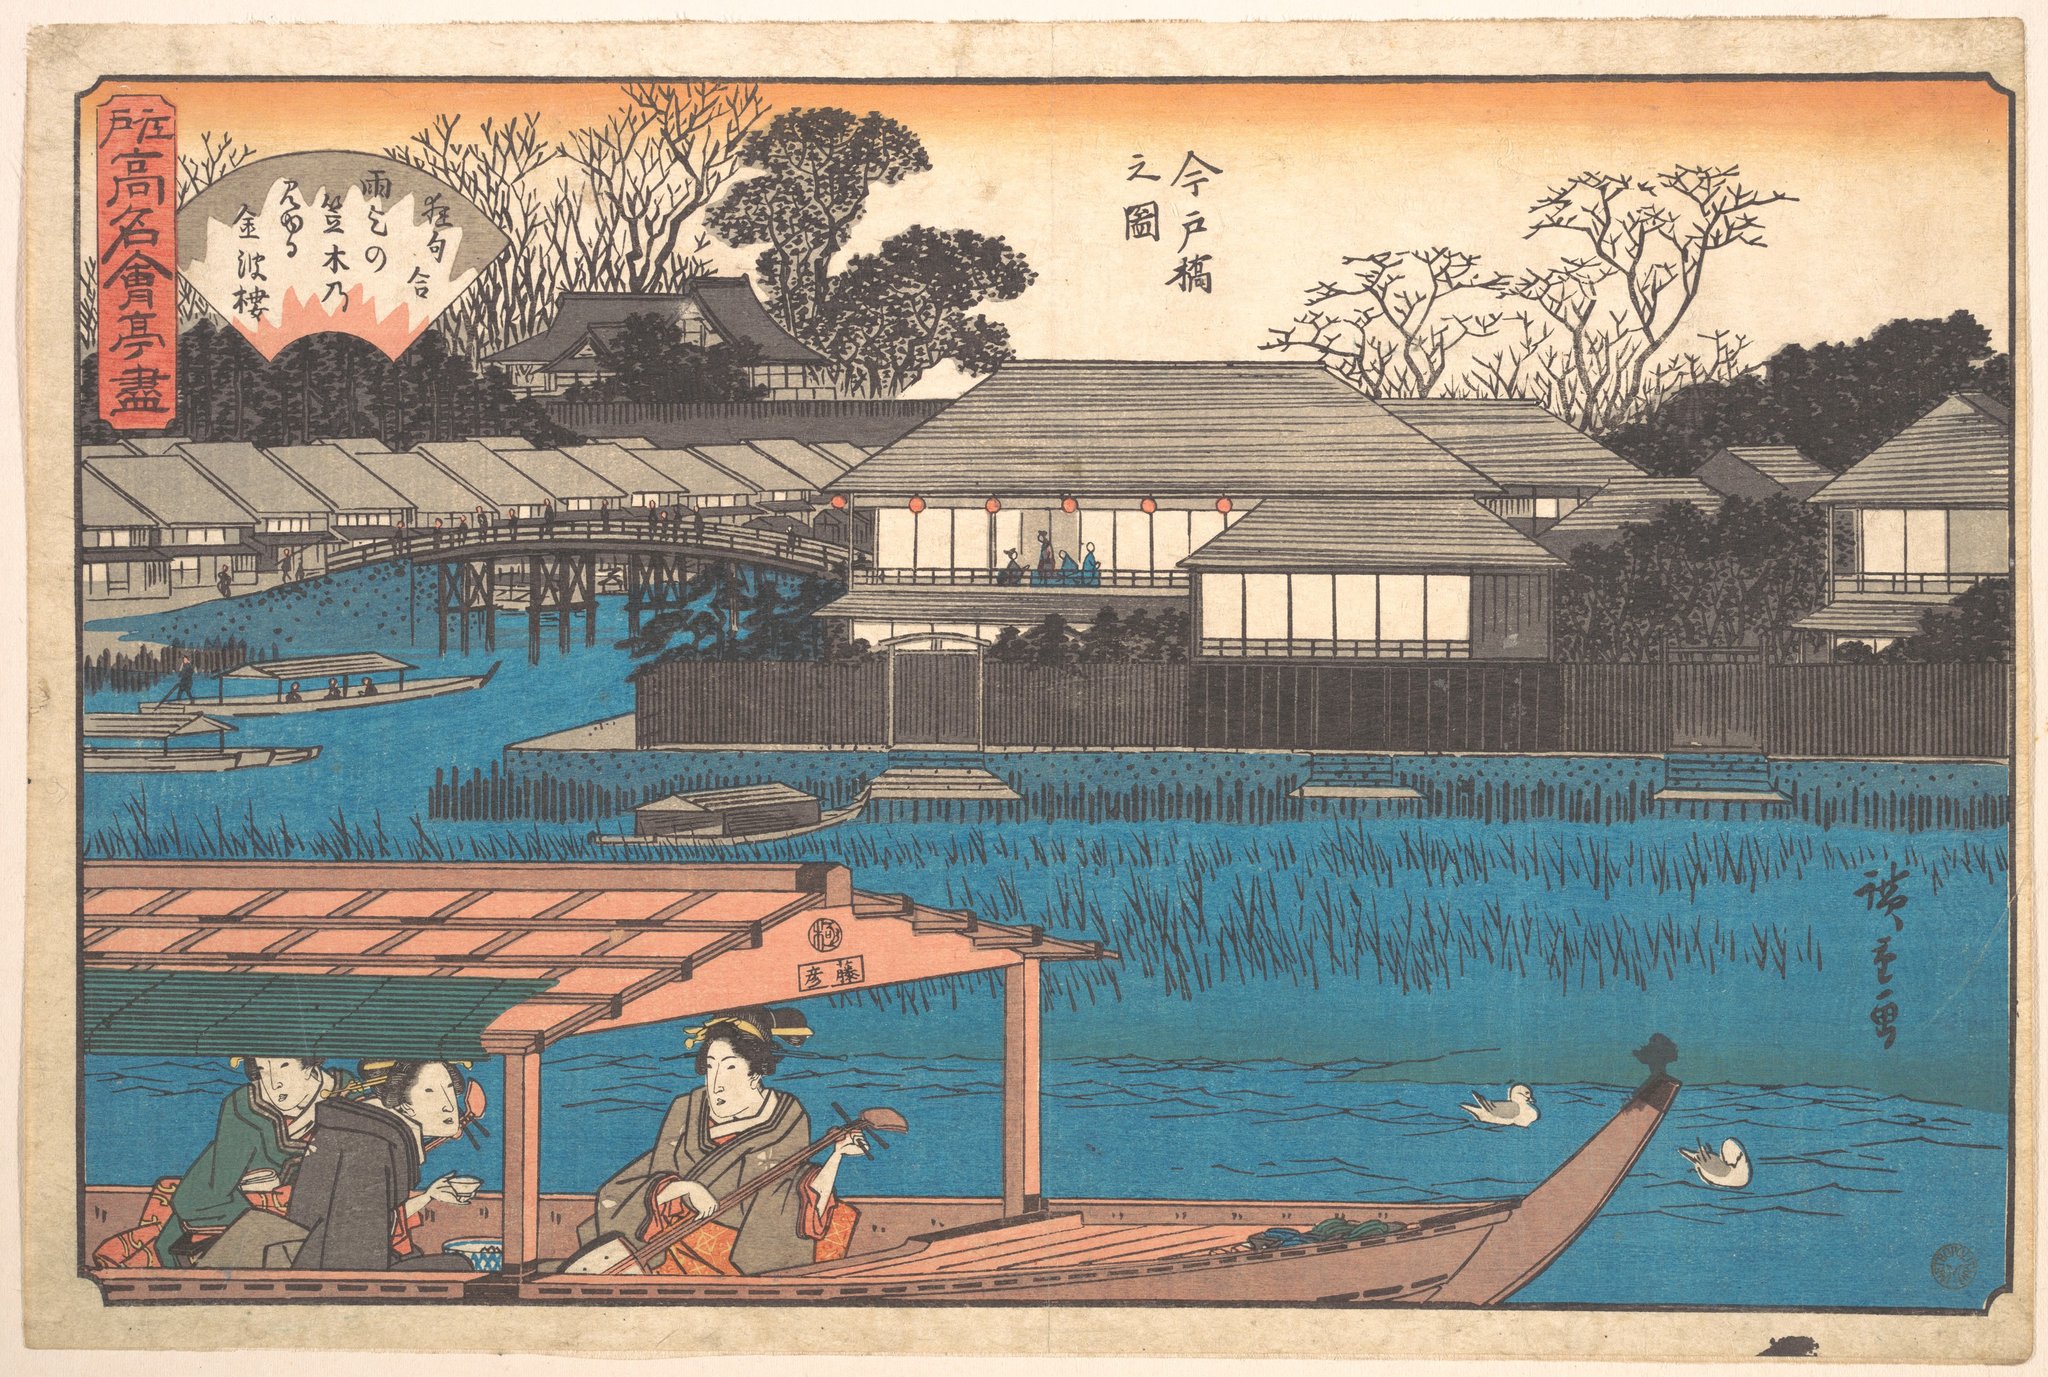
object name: print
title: Imadobashi no Zu (Tama-Sho)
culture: japanese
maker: utagawa hiroshige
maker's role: artist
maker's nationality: japanese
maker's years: 1797-1858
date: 1840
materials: ink, paper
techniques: woodblock print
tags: musical instruments,buildings,women,boats